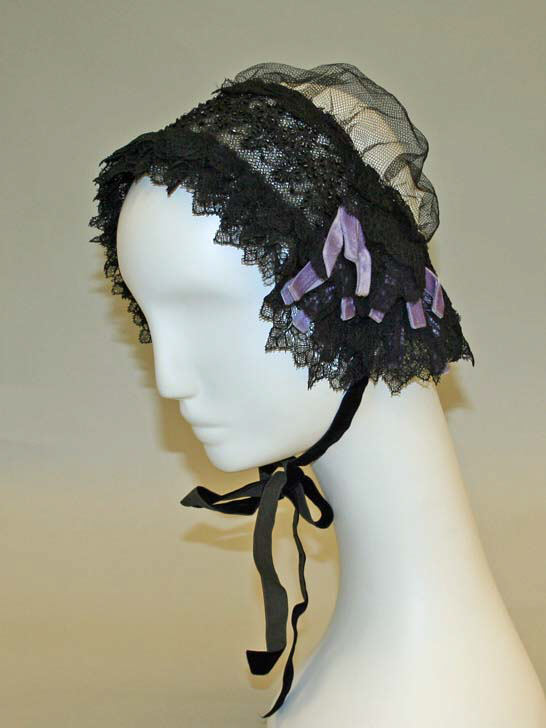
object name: cap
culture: american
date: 1847-1851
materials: silk